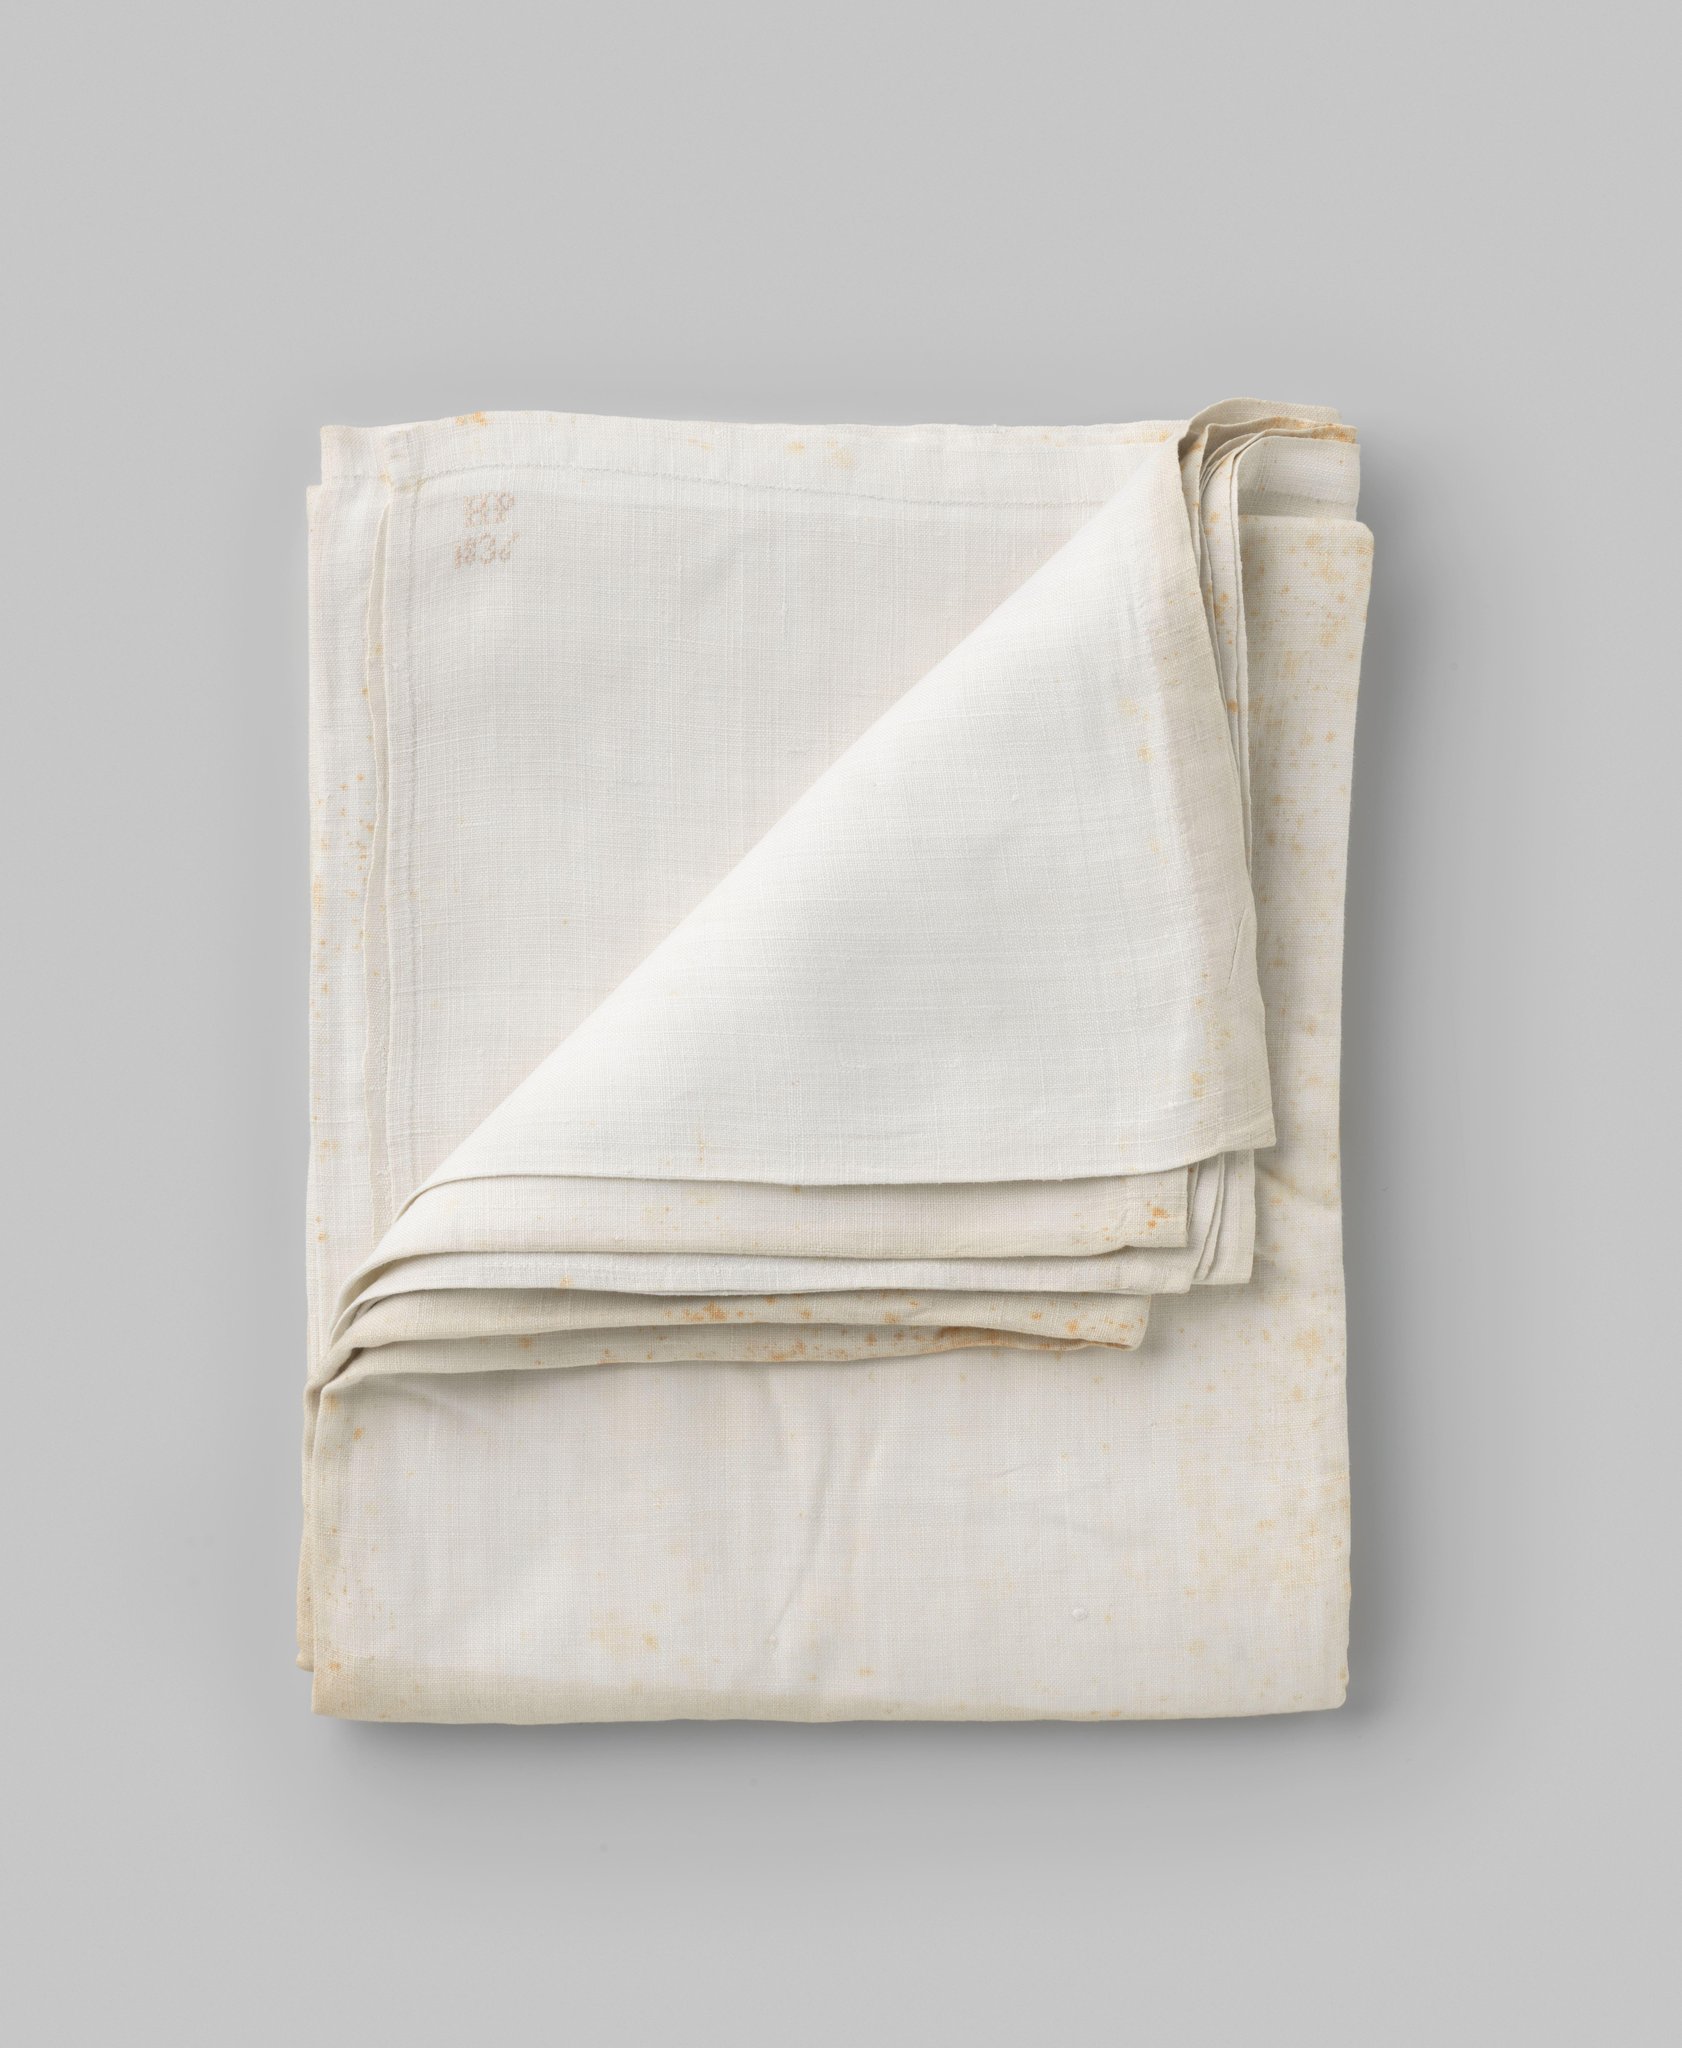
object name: beddenlaken, laken object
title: Laken. Merk: HP, 12 en jaartal 1836.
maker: Anonymous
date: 1700-1799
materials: linen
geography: northern netherlands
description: Laken van wit linnen, merk HP 1836 en 12